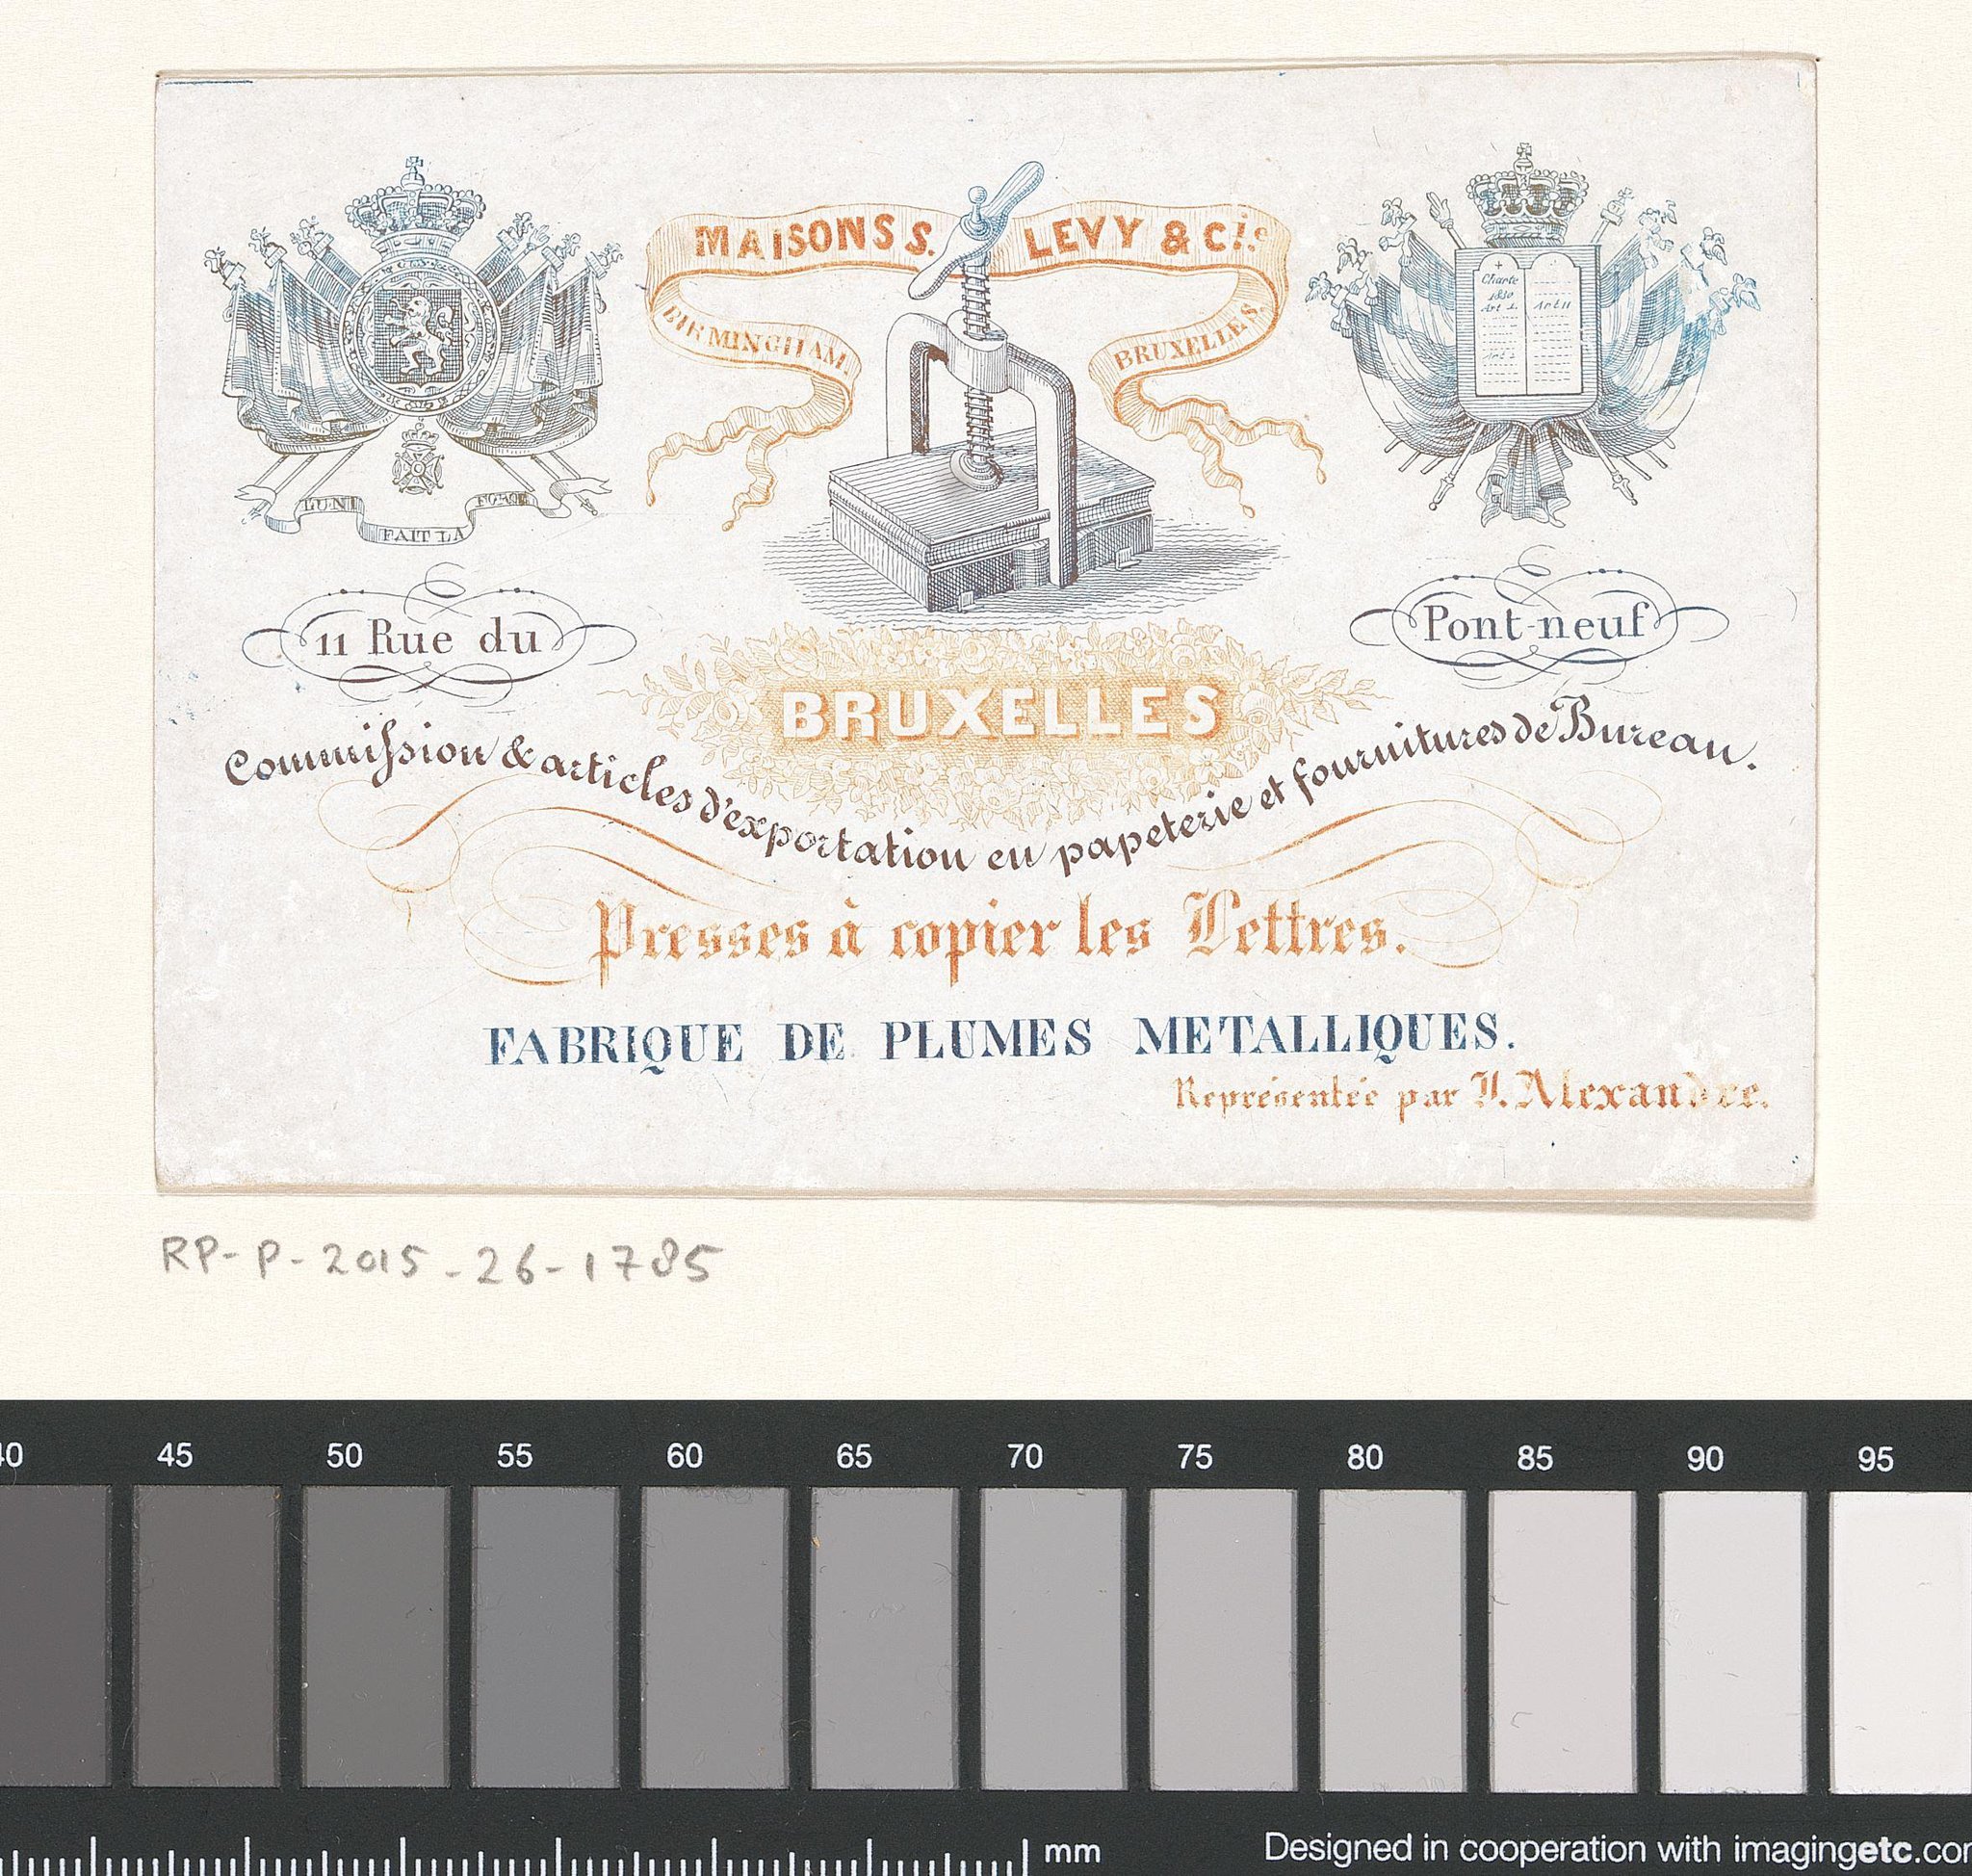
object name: visiting card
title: Visitekaartje van Maison S. Levy & Cie, verkoper van kantoorartikelen te Brussel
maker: Anonymous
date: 1840-1875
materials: porcelainized cardboard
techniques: lithograph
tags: book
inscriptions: collector's mark: Lugt 2228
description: Een kopieerpers met links het wapen van België en rechts een wapenschild met het charter van 1830.